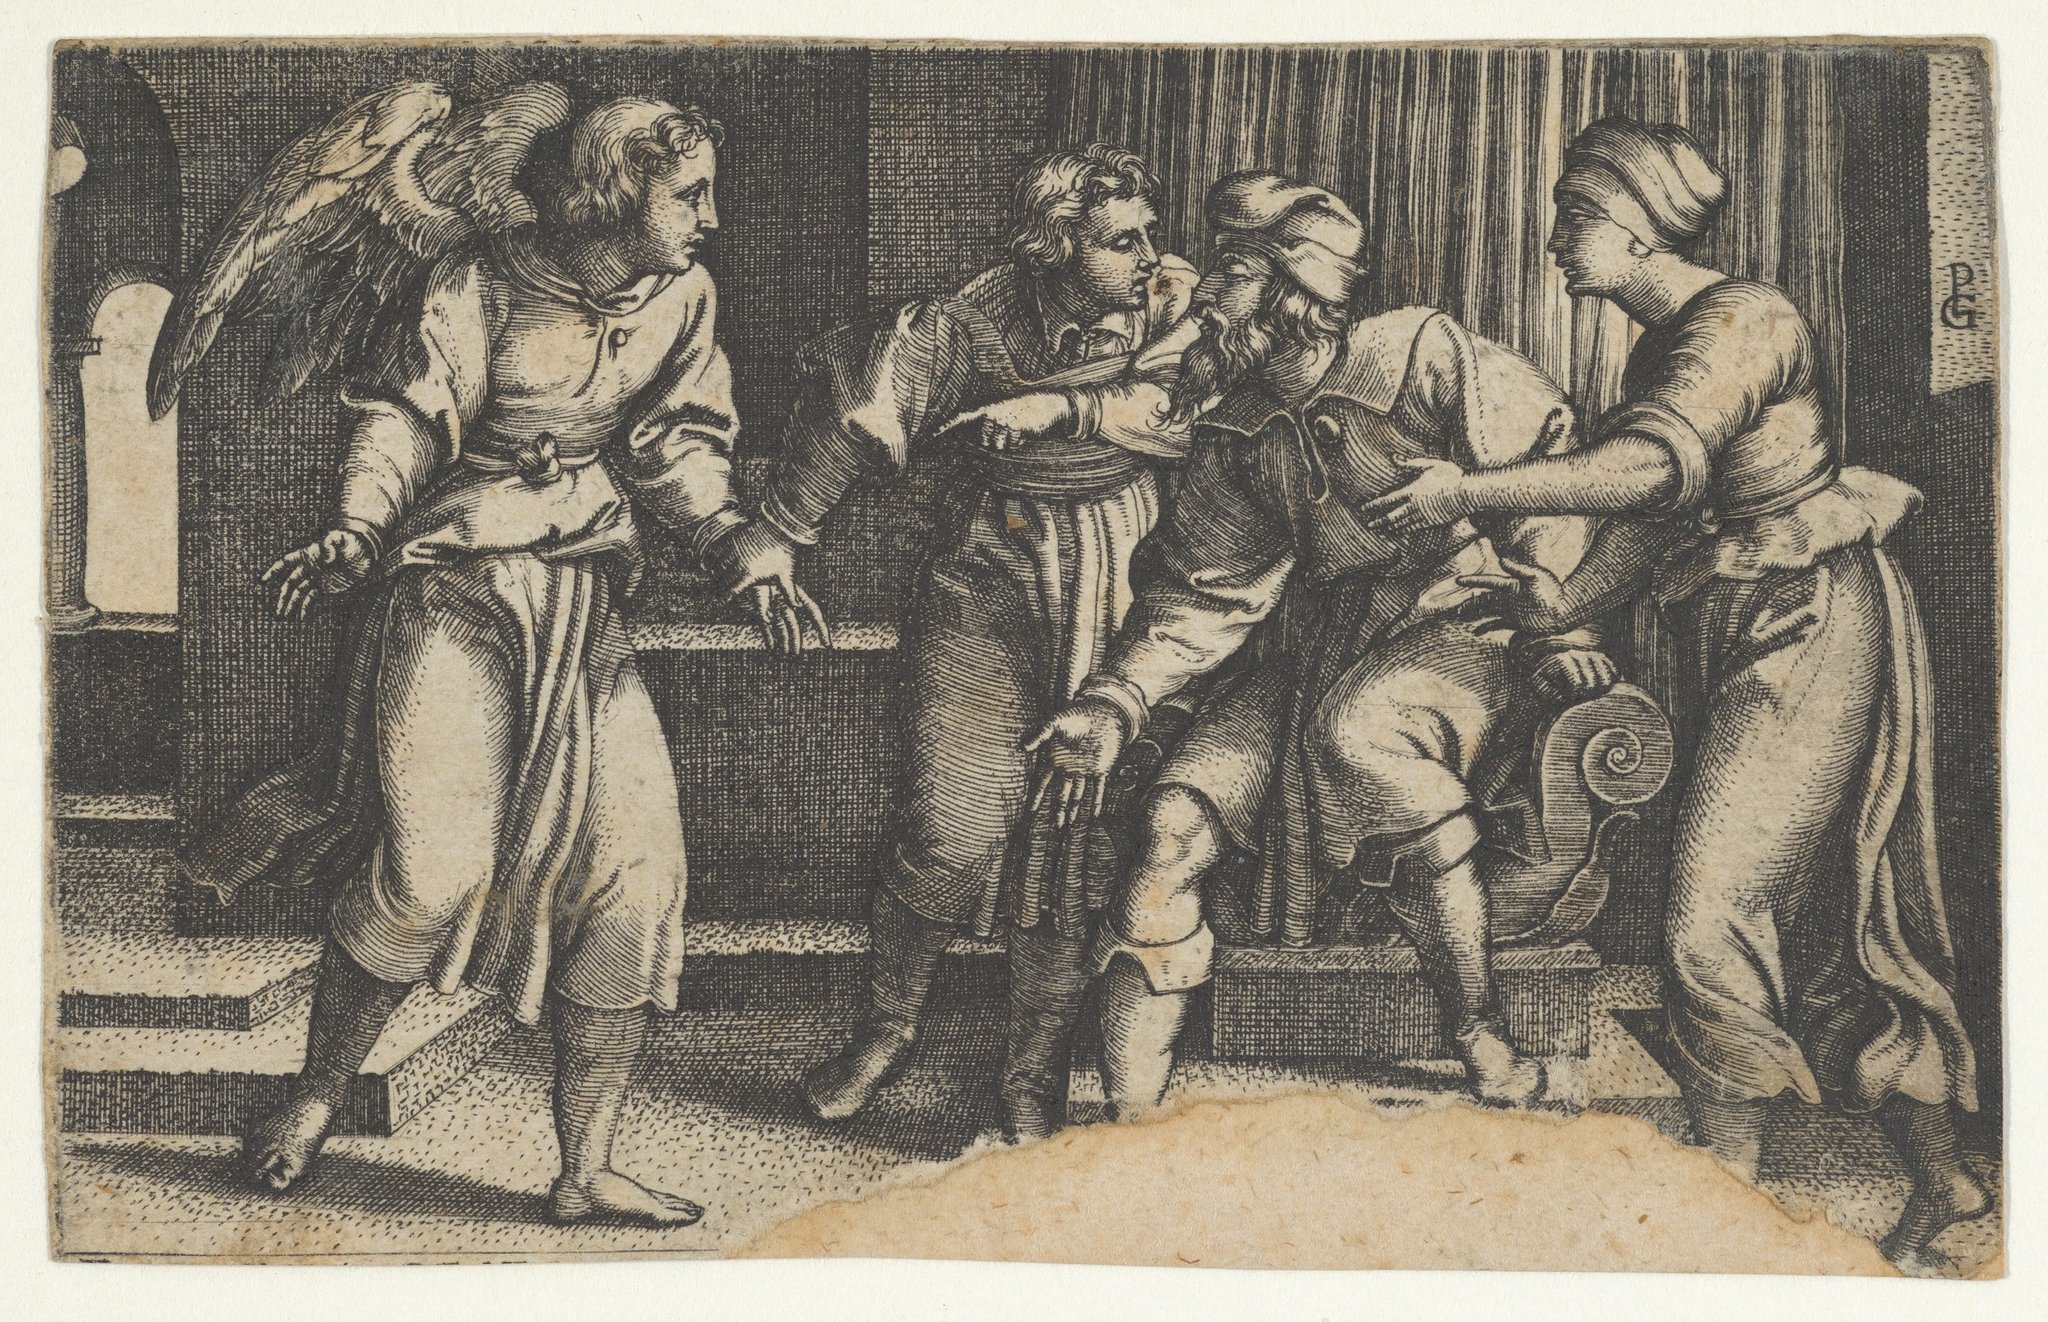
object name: print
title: Tobias and the Archangel Raphael, from "The Story of Tobias"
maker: georg pencz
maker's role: artist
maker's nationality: german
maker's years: 1500-1550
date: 1543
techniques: engraving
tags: men,angels